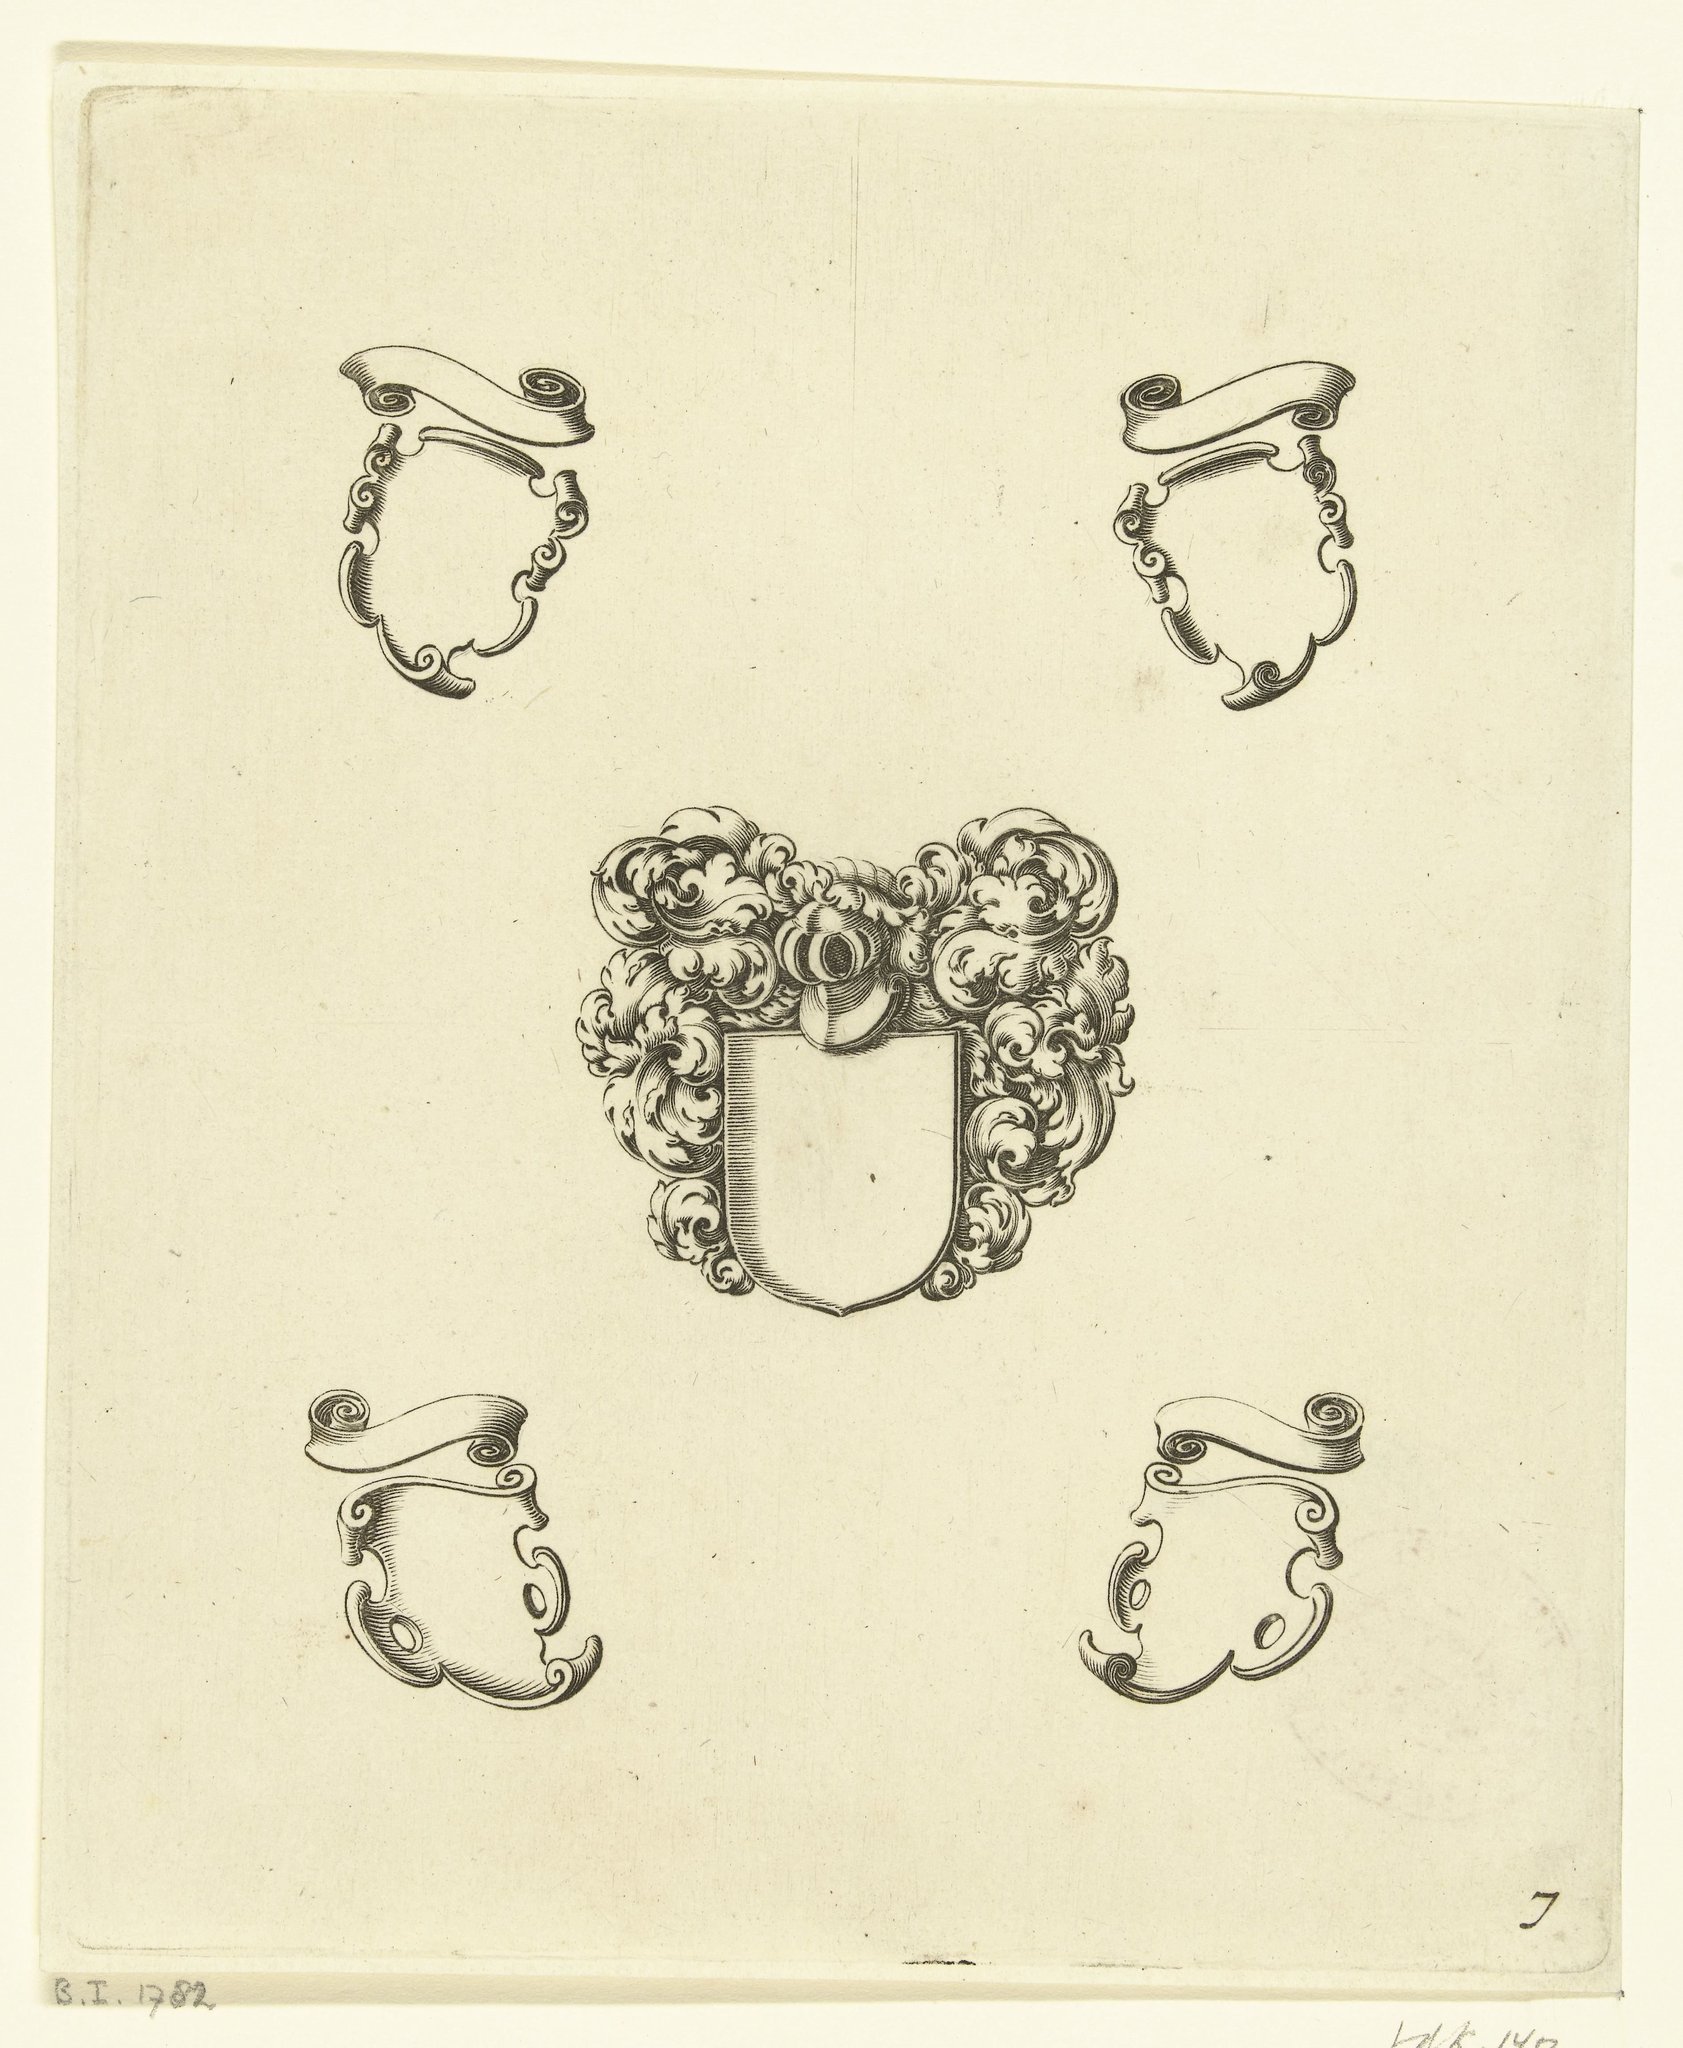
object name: print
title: Verscheyden Wapen-Schilden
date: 1612-1625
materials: paper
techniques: engraving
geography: amsterdam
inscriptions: collector's mark: Lugt 240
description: Tegenzijdige kopie, met lege schilden en lege banderollen.